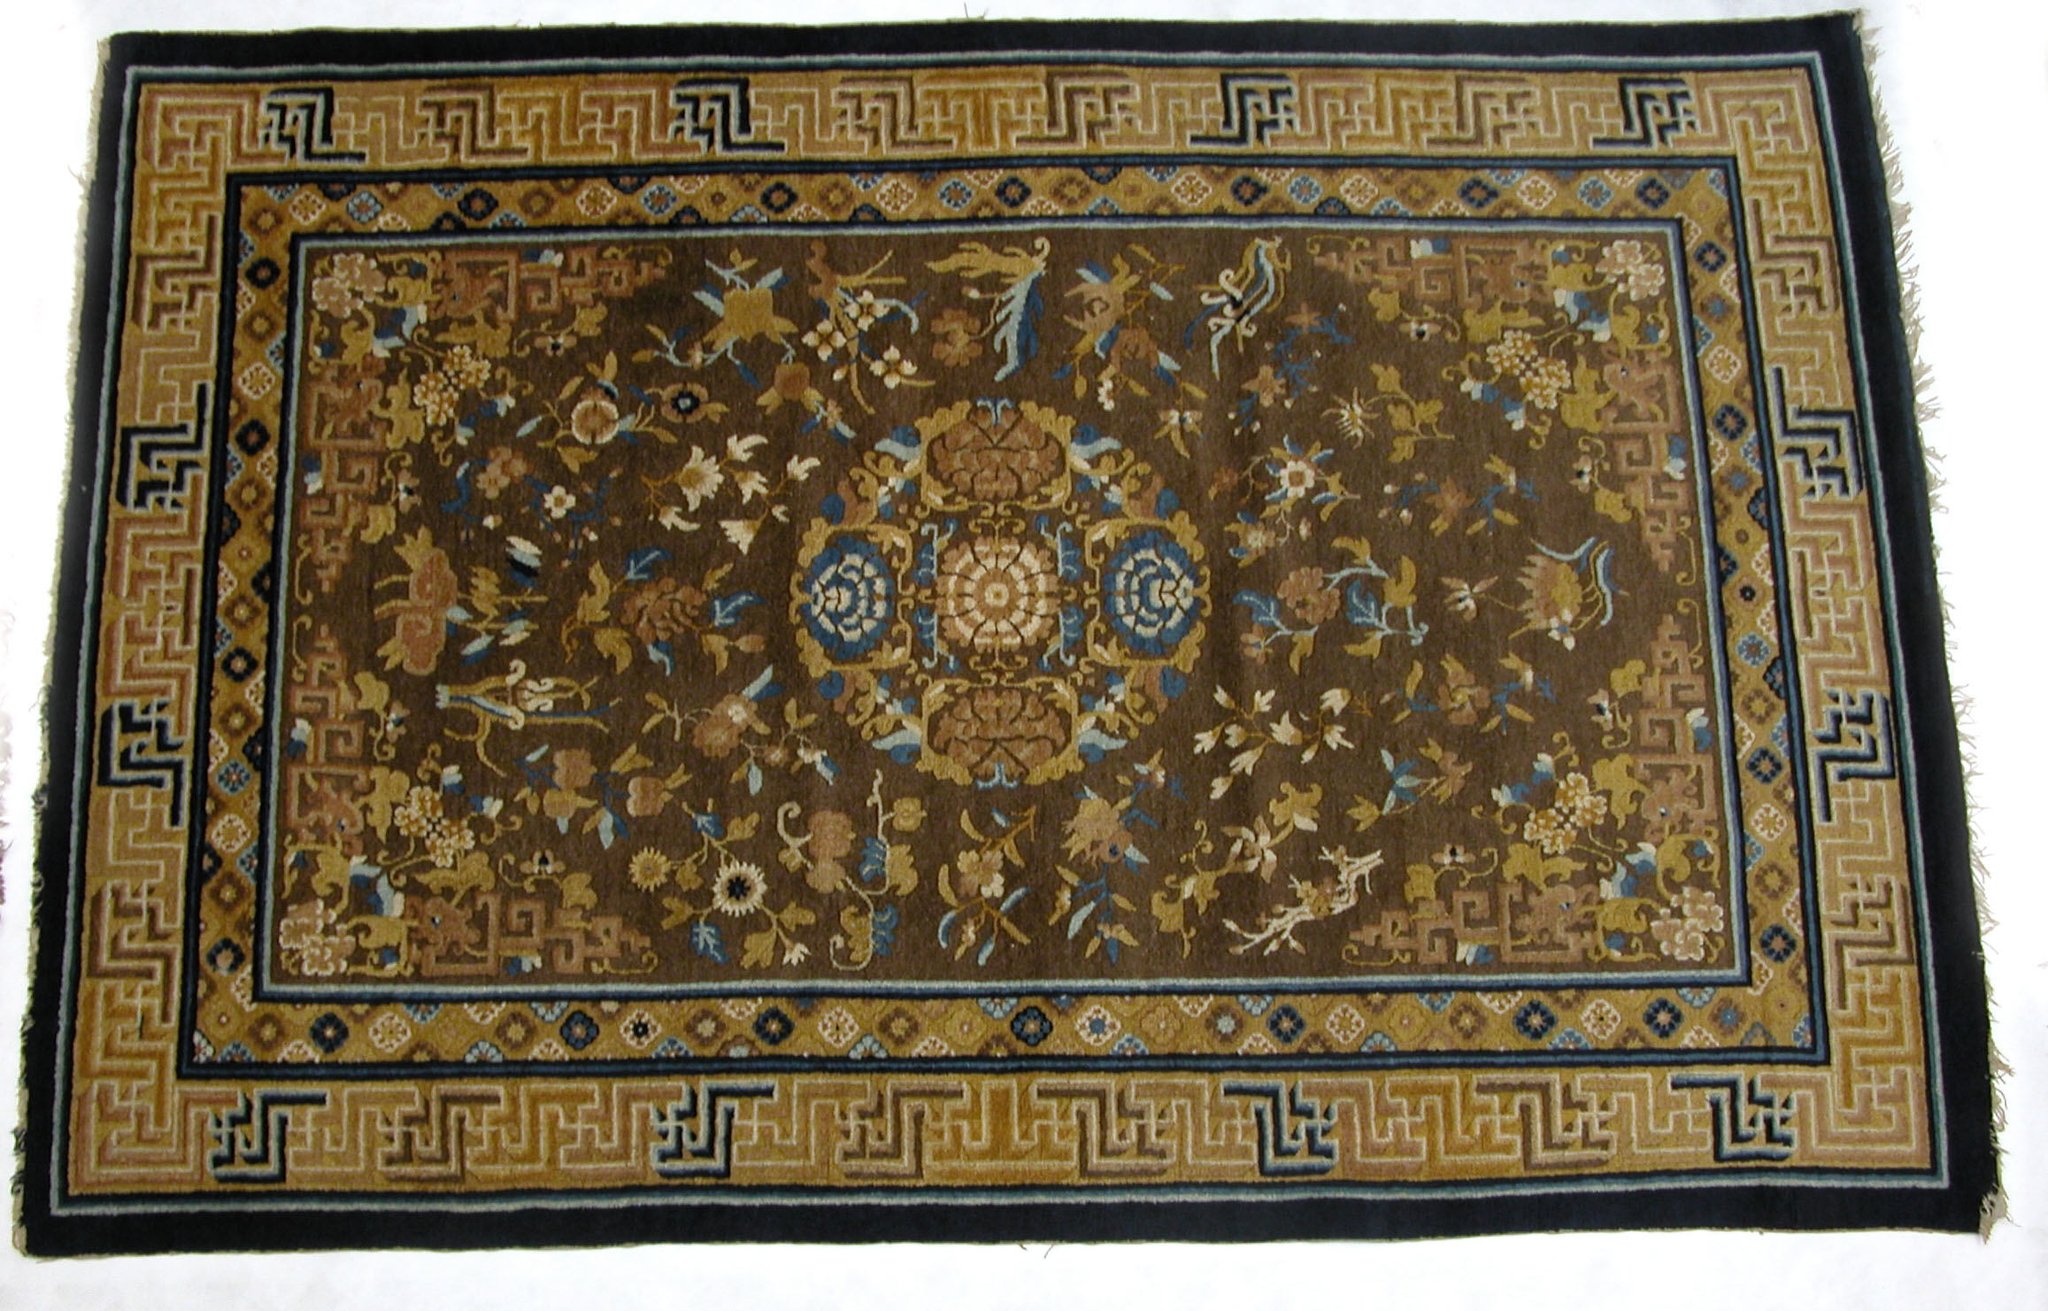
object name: rug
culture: chinese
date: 1867-1933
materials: cotton, wool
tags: flowers